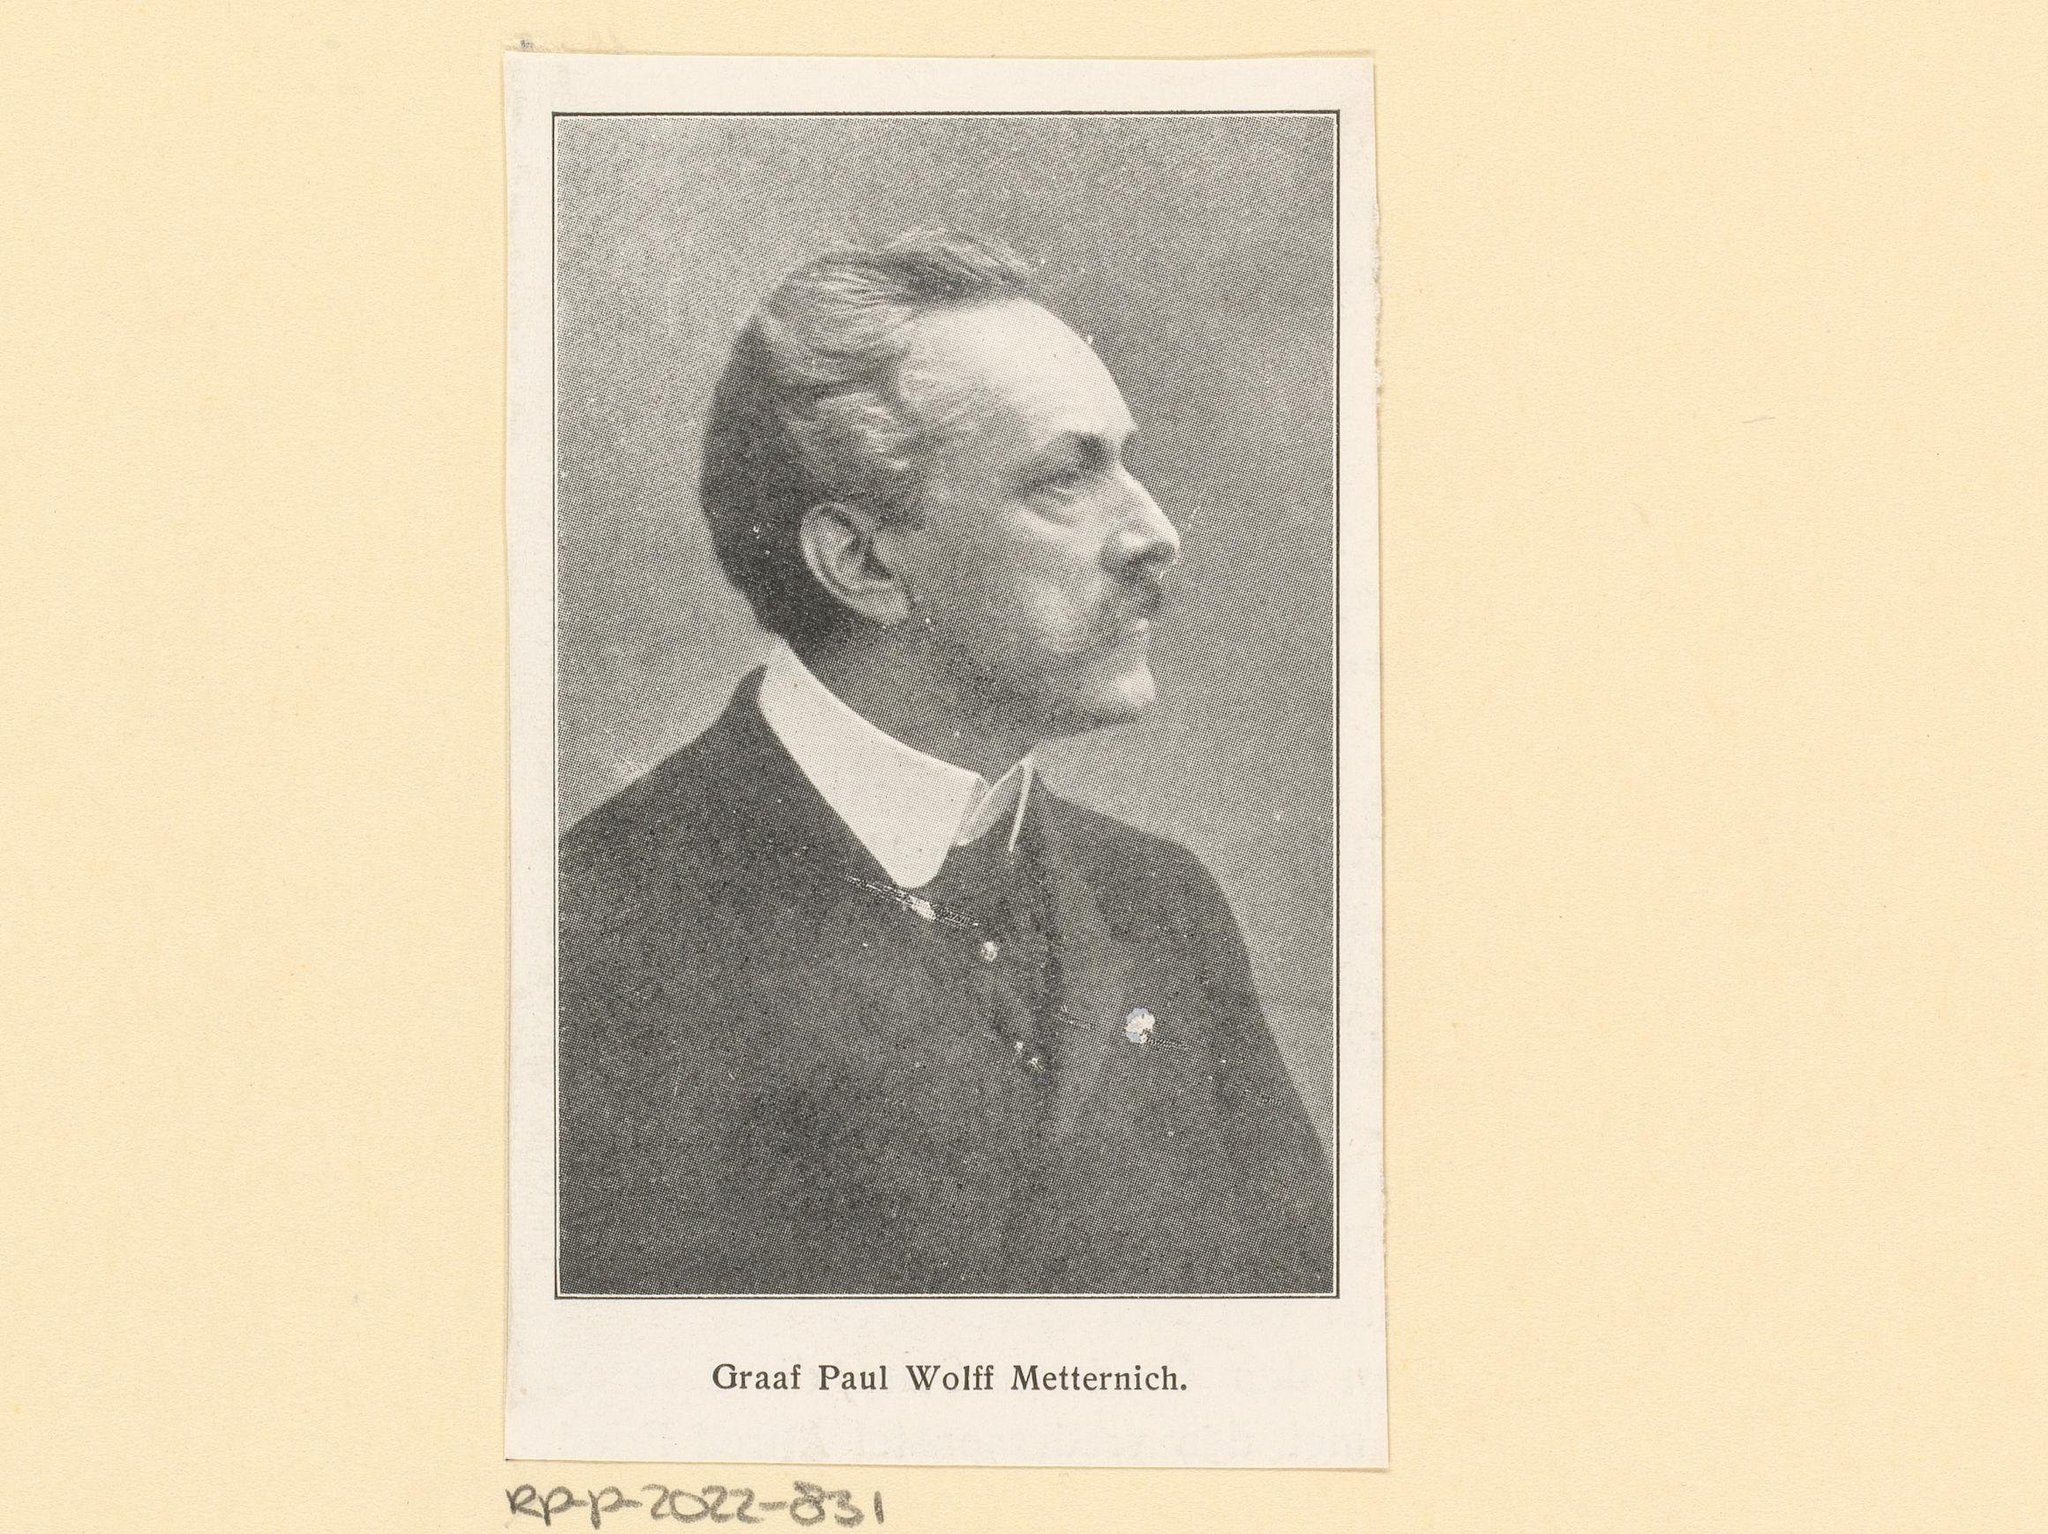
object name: photomechanical print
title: Portret van Paul Wolff Metternich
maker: Anonymous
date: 1912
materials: paper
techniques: autotype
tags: historical persons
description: Cliché uit: Op de hoogte 9 (1912), maart 1912, p. 3.